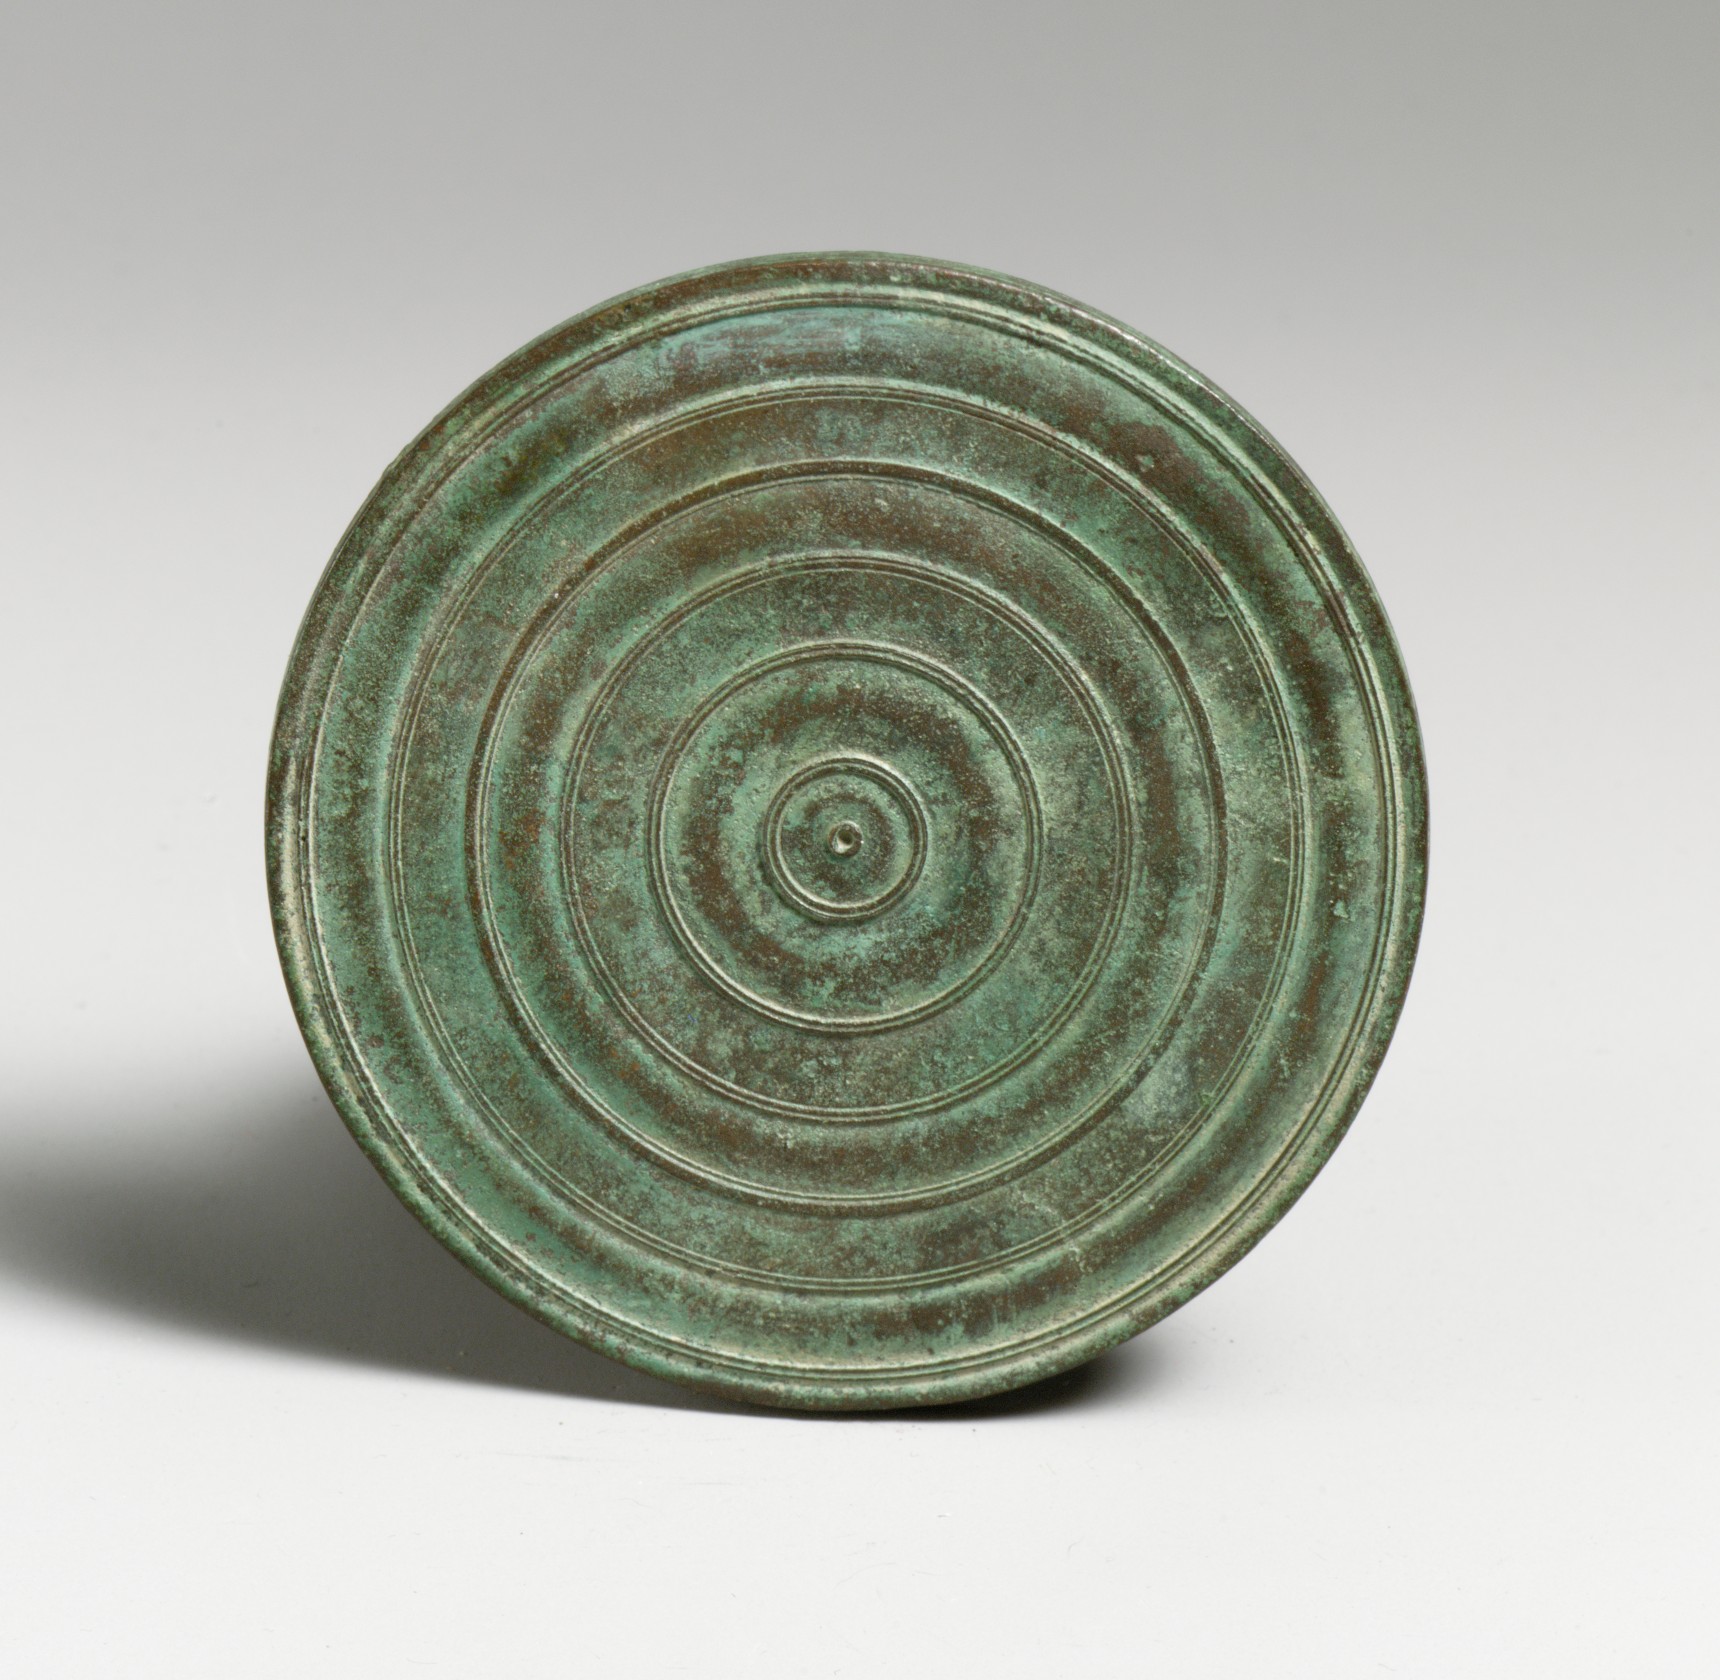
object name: mirror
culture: greek, cypriot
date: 7000-30 BCE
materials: bronze